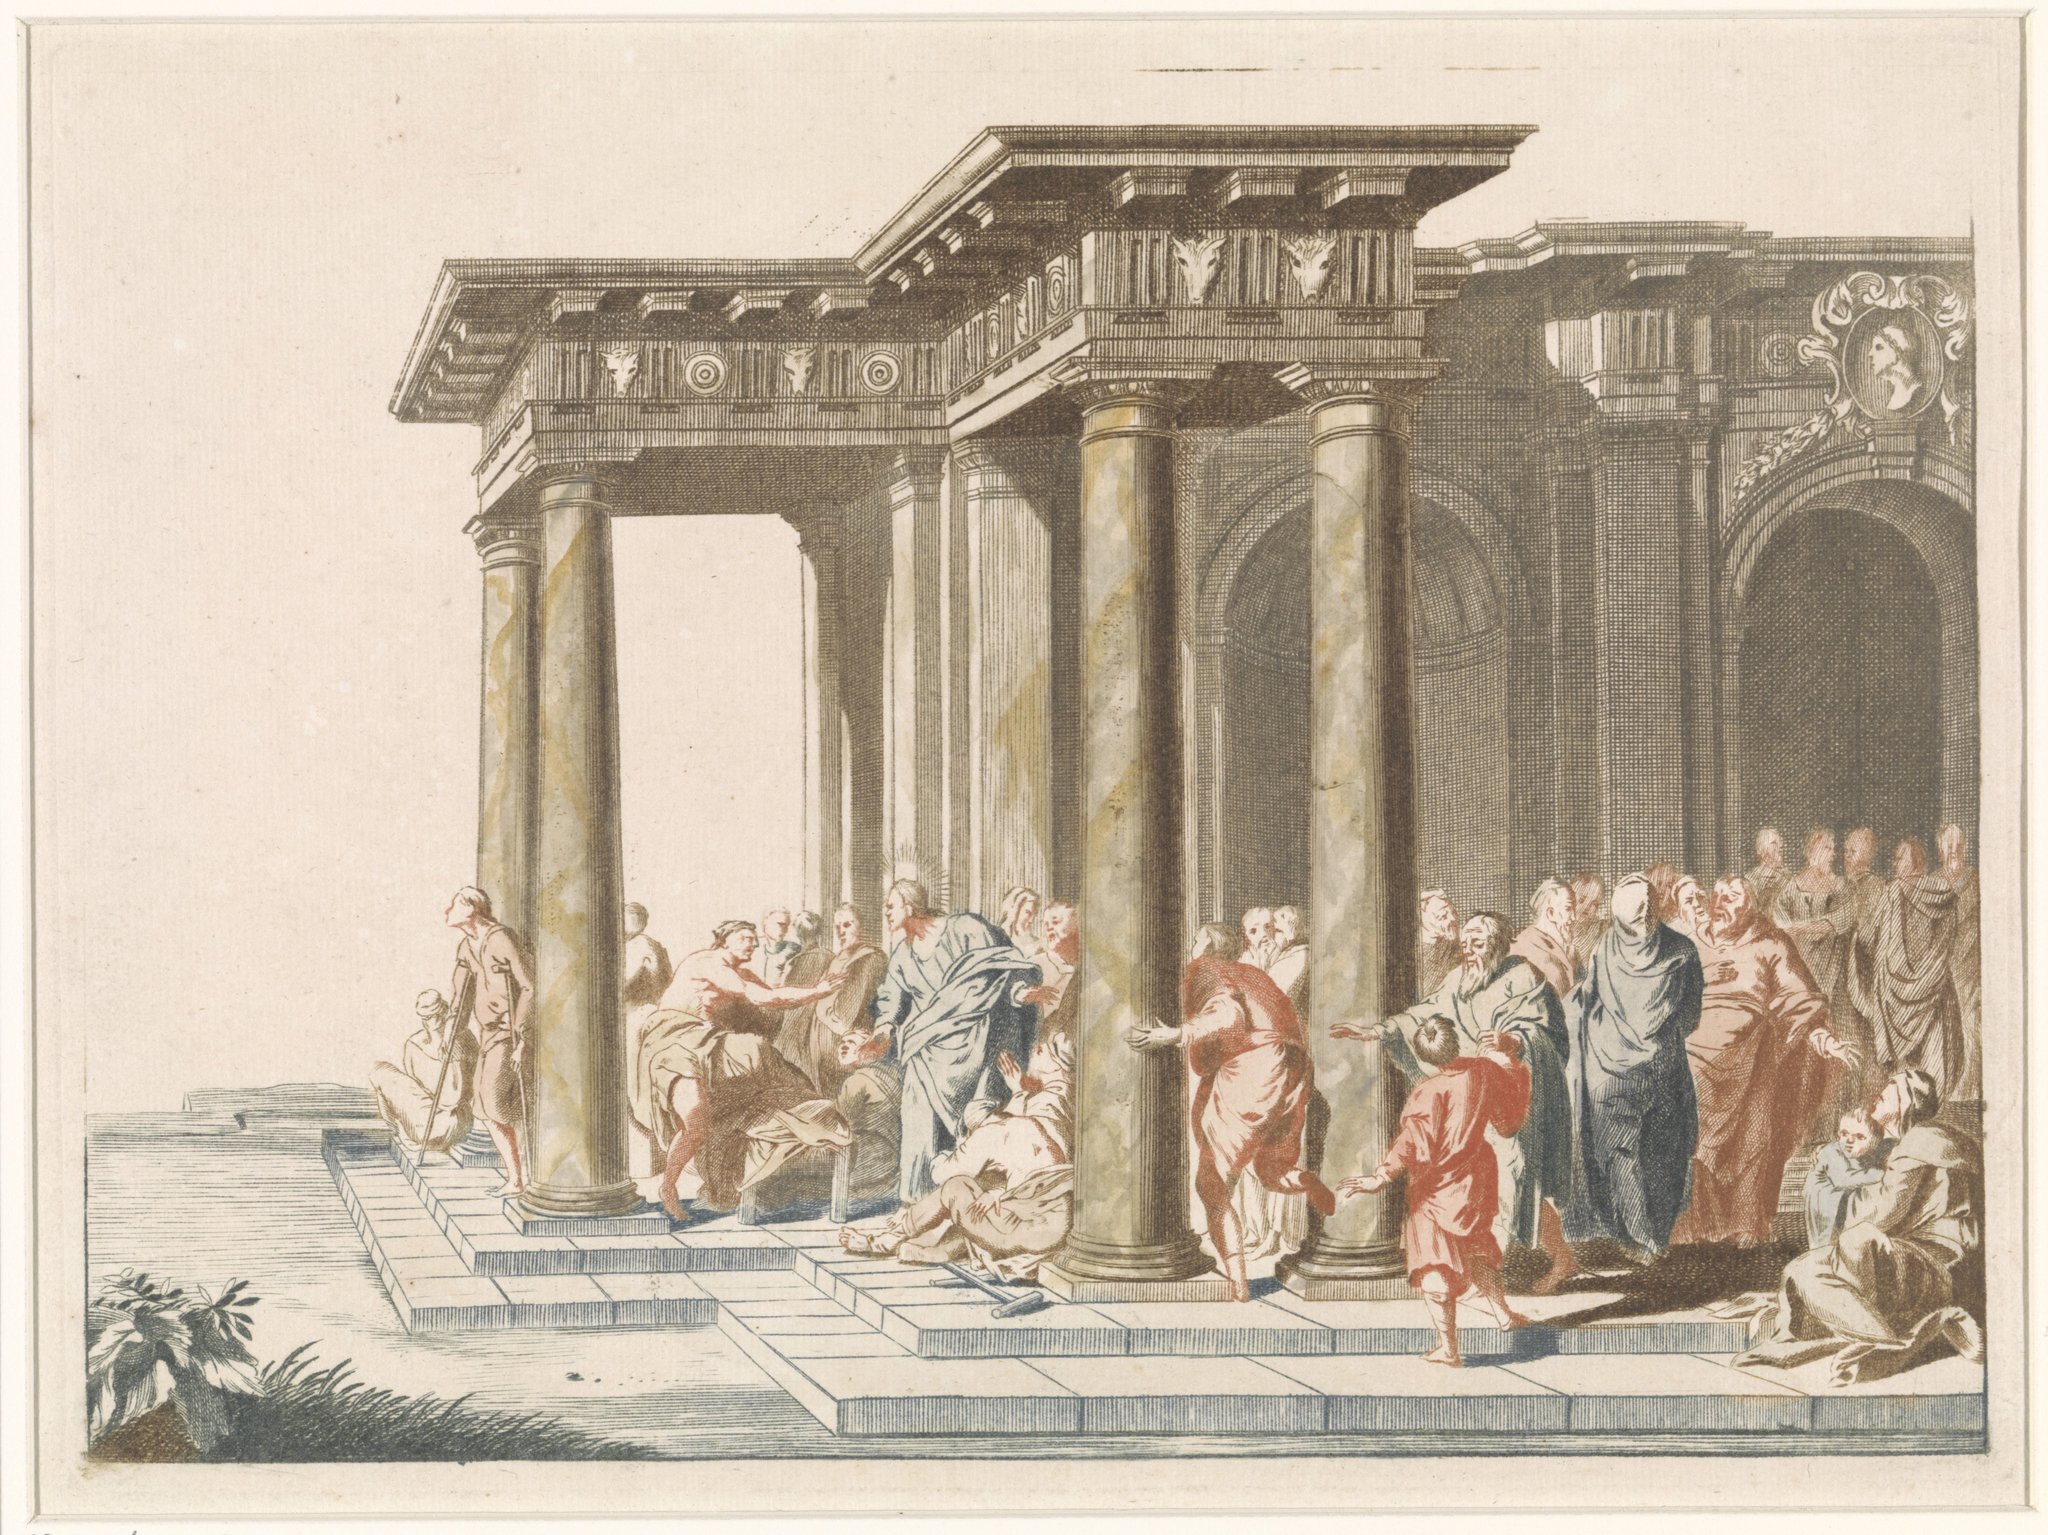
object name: print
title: Christus geneest een man bij het bad van Betesda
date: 1688-1698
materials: paper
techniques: engraving, etching, hand coloring, lithography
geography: netherlands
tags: crutches, christ says to a paralytic man: 'rise, take up your pallet (bed)', sick people lying near the pool of bethesda ~ christ healing paralytics (john 5:1-9)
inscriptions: collector's mark: Lugt 2228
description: Genezing op sabbat. Christus geneest de verlamde man bij het bad van Betesda (Betzata). De man staat op van zijn bed. In de zuilengang hebben zieken en mensen met beperkingen zich verzameld in de hoop in het water van het bad genezen te worden.